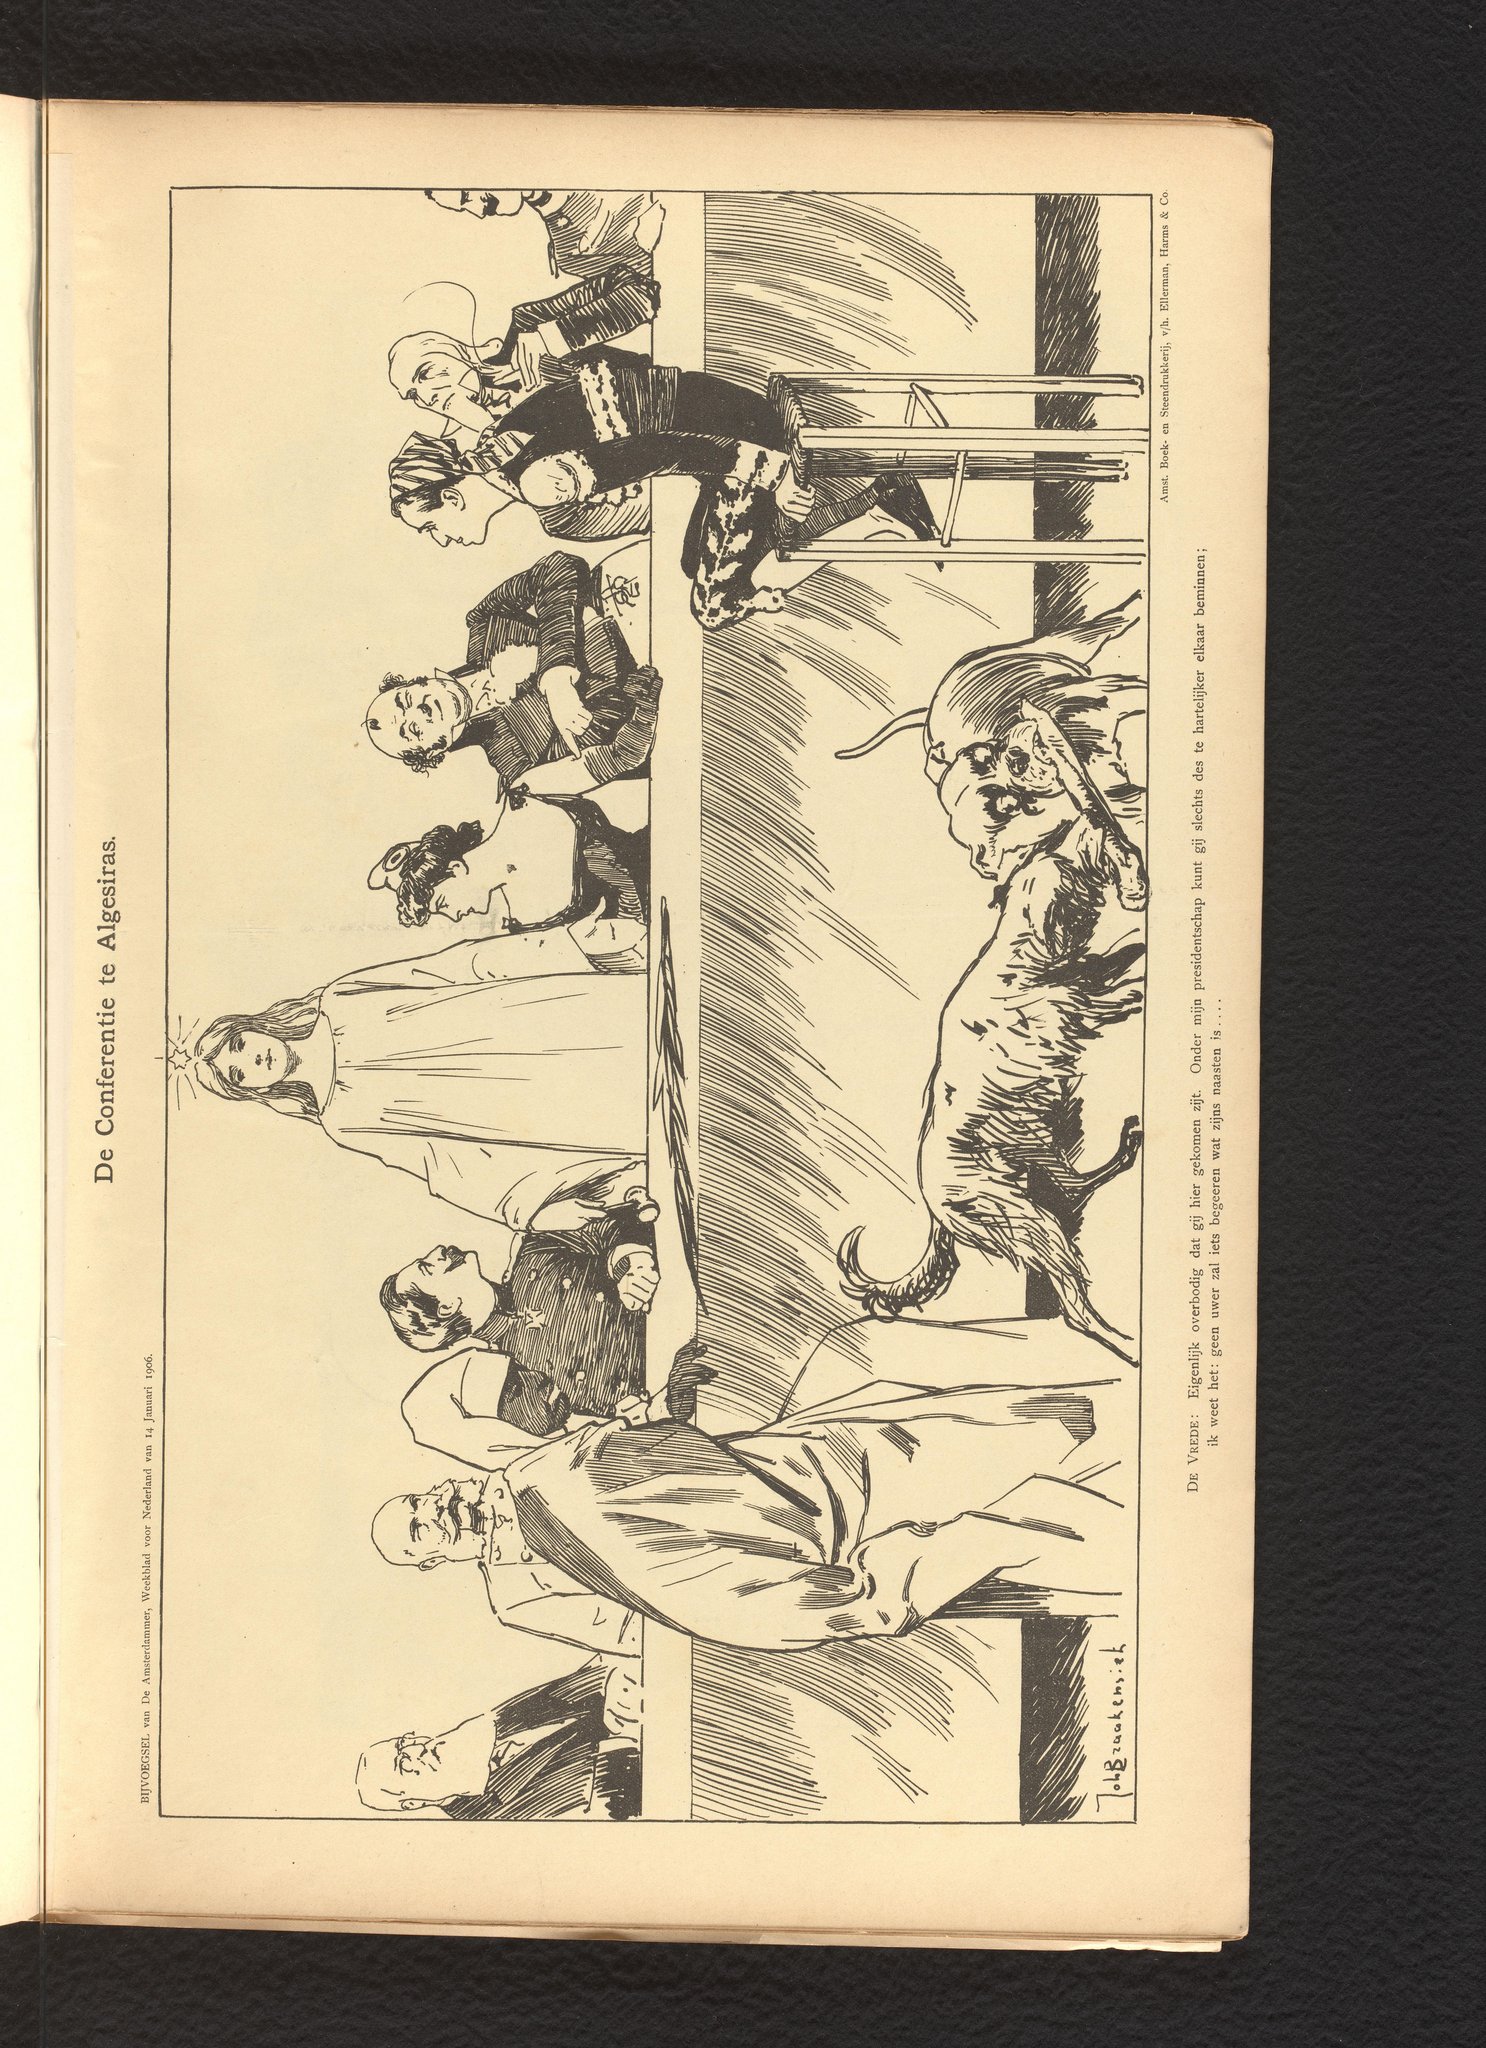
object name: cartoon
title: De Conferentie te Algesiras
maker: johan braakensiek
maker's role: draughtsman, print maker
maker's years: 1858-1940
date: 1906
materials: paper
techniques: lithograph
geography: amsterdam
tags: wilhelm ii (keizer van duitsland), personifications of countries, nations, states, districts, etc., symbols, allegories of peace, 'pax'; 'pace' (ripa), negotiations, conference ~ diplomacy, political caricatures and satires, dog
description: De leiders van de grote mogendheden samen aan tafel onder voorzitterschap van de Vrede. Ze kijken wantrouwend naar elkaar. Op de voorgrond vechten twee honden om een been. Naar aanleiding van de Internationale conventie te Algeciras over Marokko. Op de voorgrond namens Marokko: Muhammad al-Muqri.